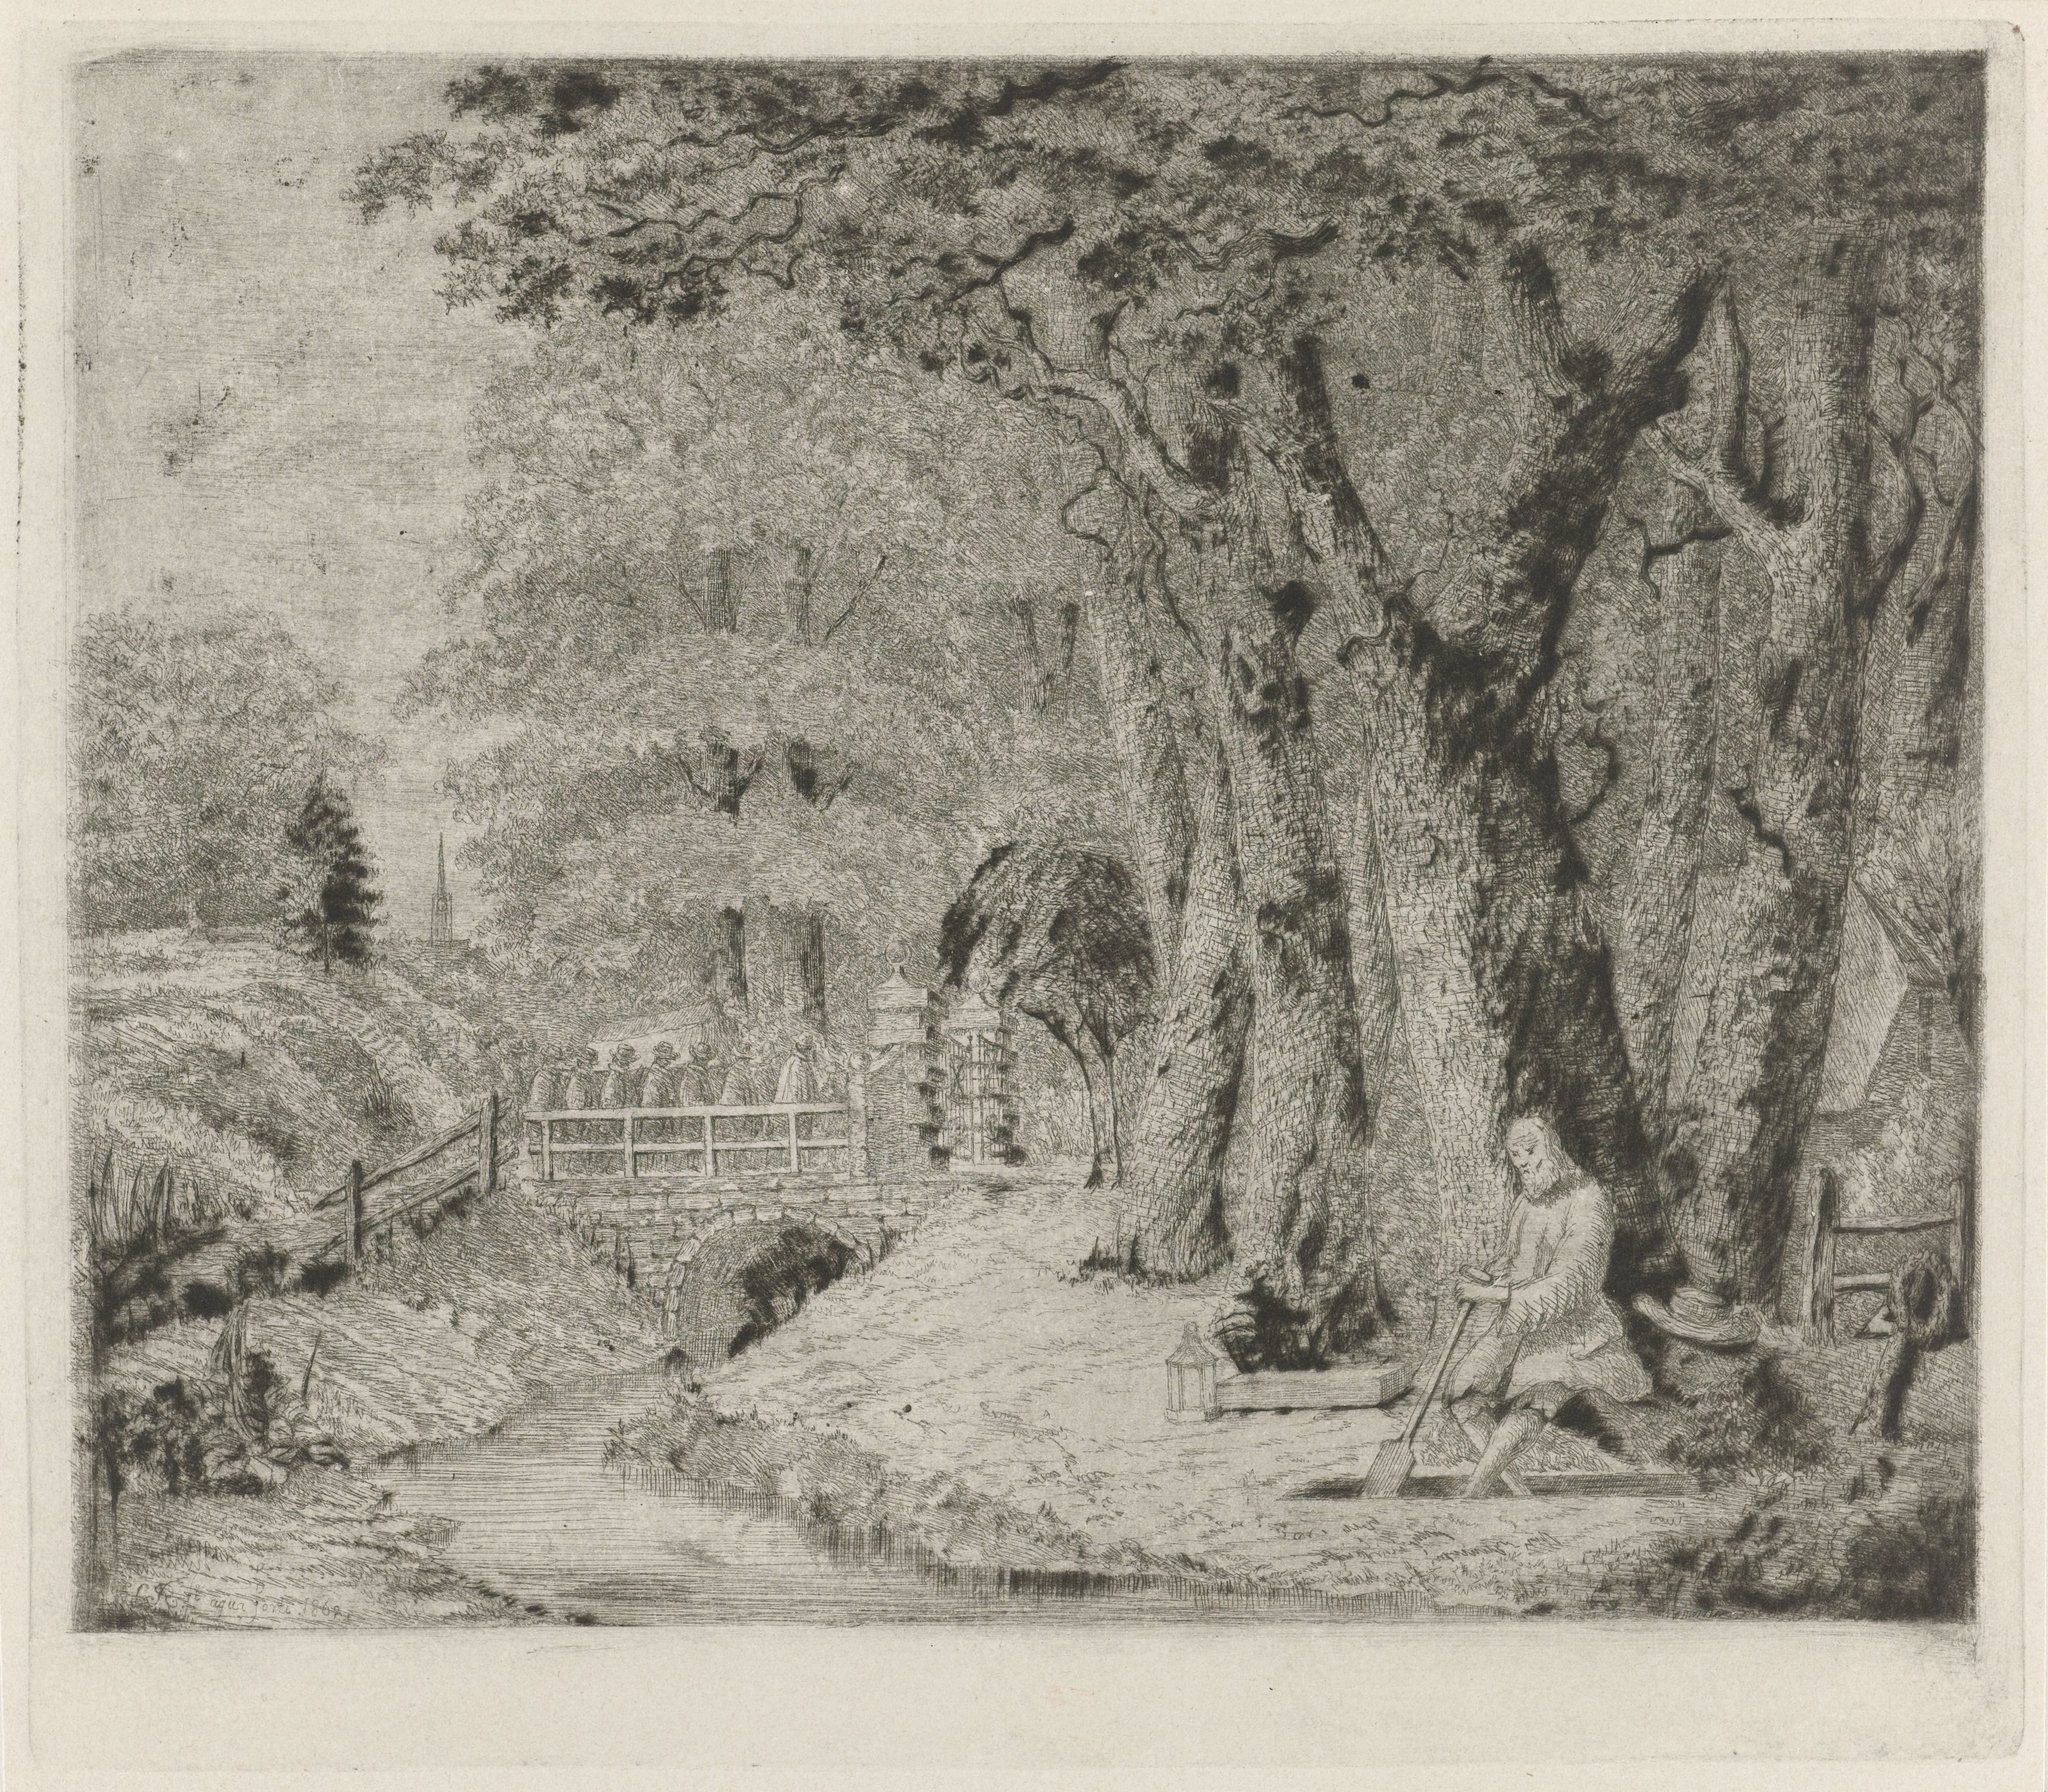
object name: print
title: De Doodgraver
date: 1862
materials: paper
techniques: drypoint, etching, intaglio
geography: oudewater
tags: cortege, funeral procession, grave digger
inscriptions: collector's mark: Lugt 2228, inscription: ‘De doodgraver / naar Tollens / ECR inv [...]’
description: Aan de waterkant, onder geboomte, graaft een doodgraver een graf. Op de achtergrond een brug met de begrafenisstoet met de kist.